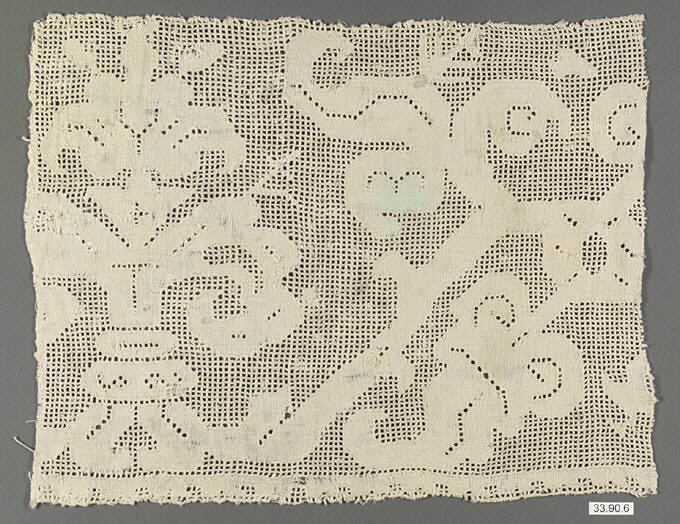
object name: fragment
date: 1501-1600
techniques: embroidery